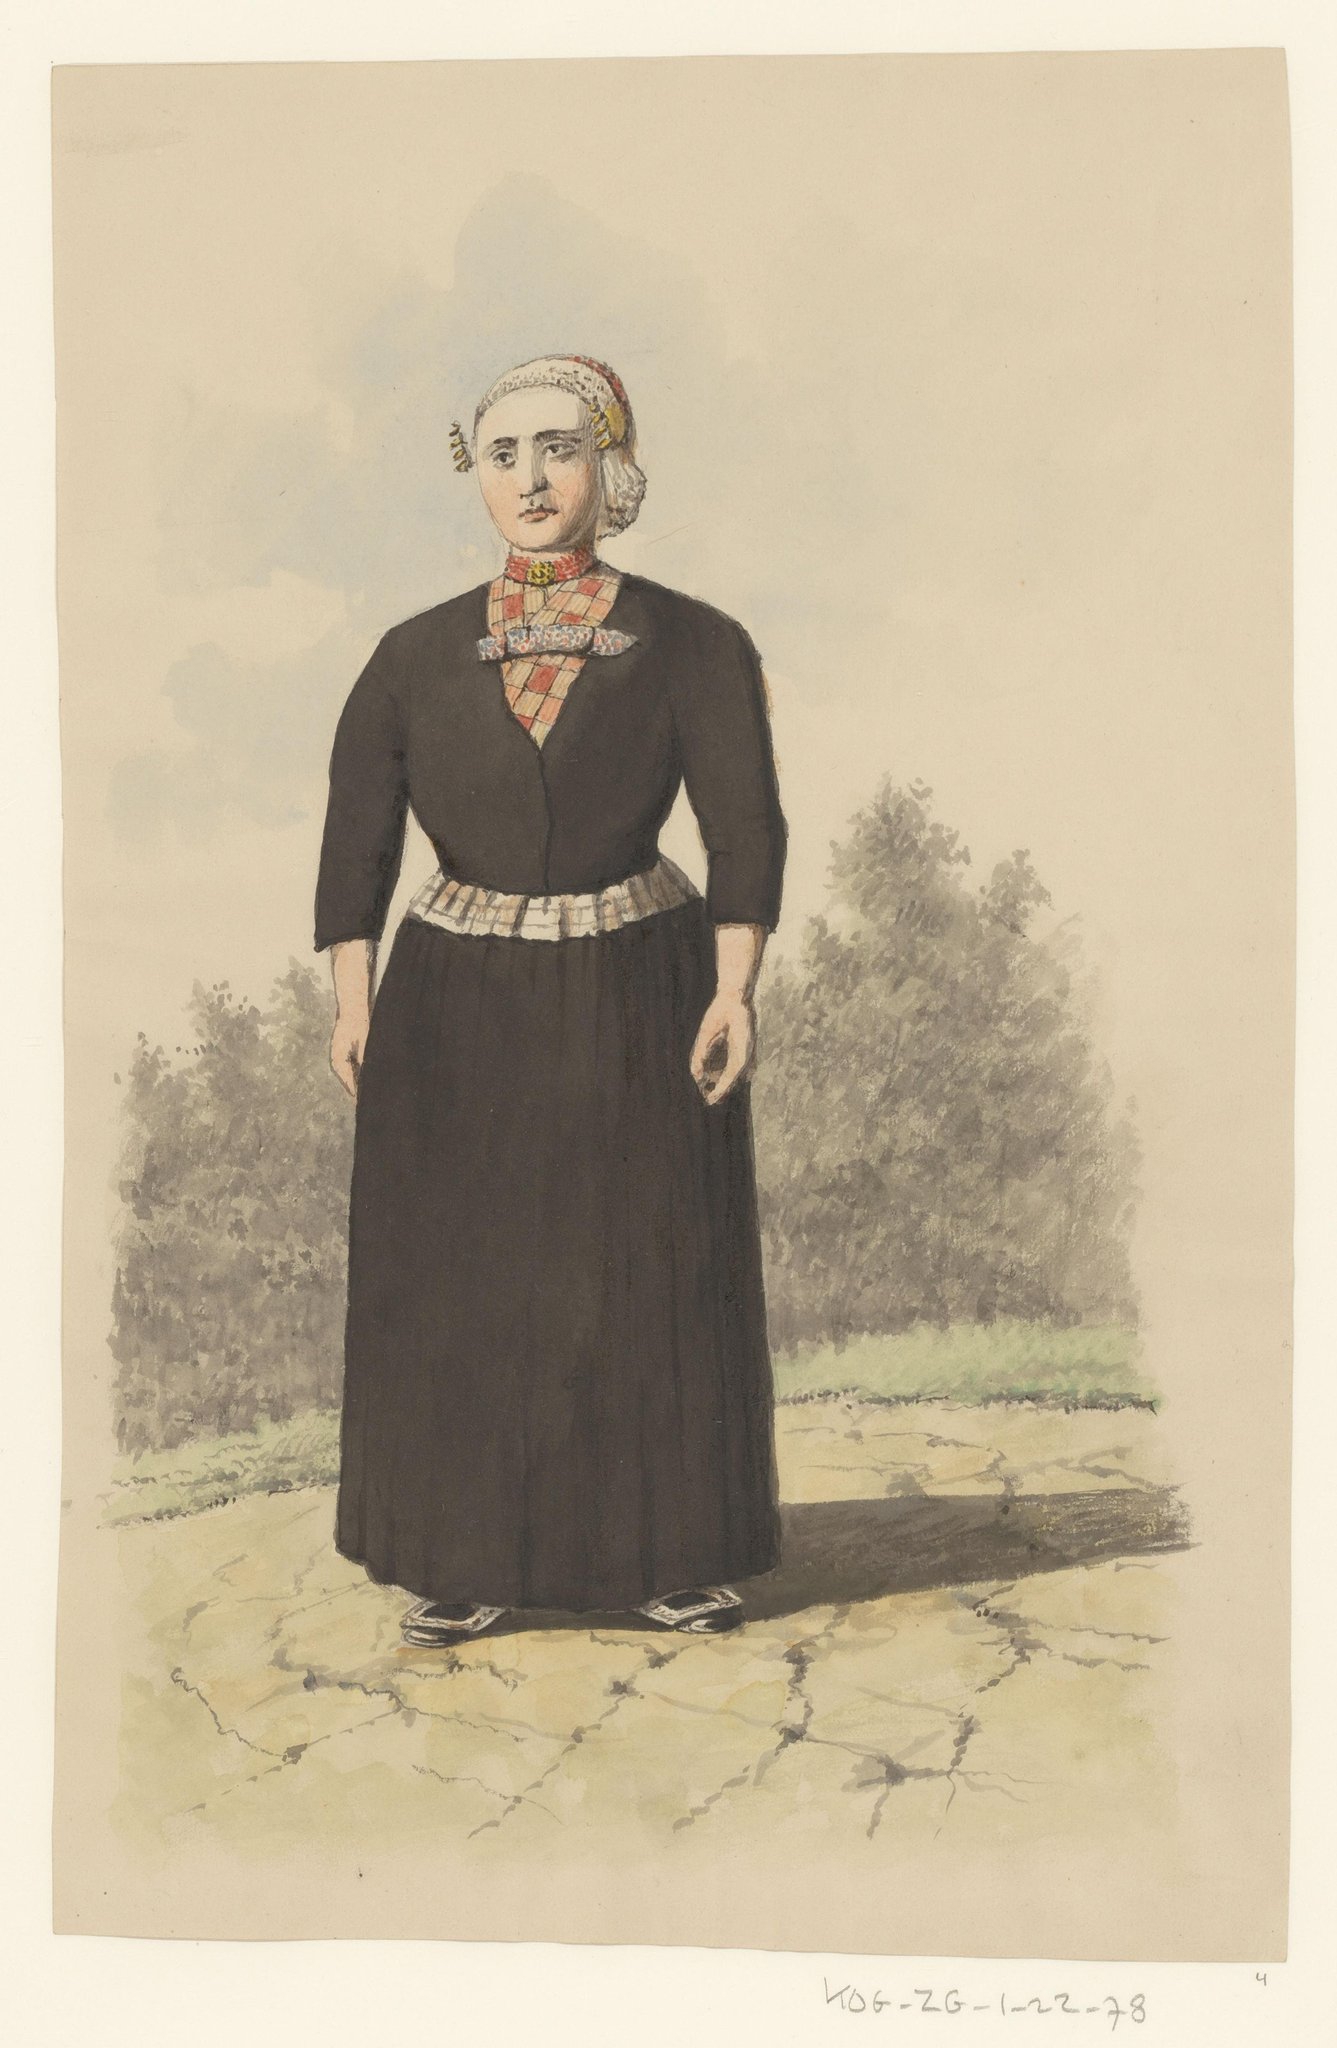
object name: drawing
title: Boerin uit Doornspijk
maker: johan martinus anthon rieke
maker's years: 1851-1899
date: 1896-1898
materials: paper, watercolor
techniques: brush, hand coloring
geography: netherlands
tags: farmers - aa - female farmer, farmer's wife, clothes, costume (+ women's clothes), folk costume, regional costume, gelderland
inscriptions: collector's mark, collector's mark: Lugt 1641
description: Boerin uit Doornspijk, Gelderland, onderweg naar de markt. Tekening vervaardigd voor de tentoonstelling over Nederlandse klederdrachten gehouden in het Stedelijk Museum te Amsterdam in september 1898. Onderwerpsrubrieken binnen de Atlas Zeden en Gewoonten: De Kleeding, Volkskleederdracht, Gelderland.